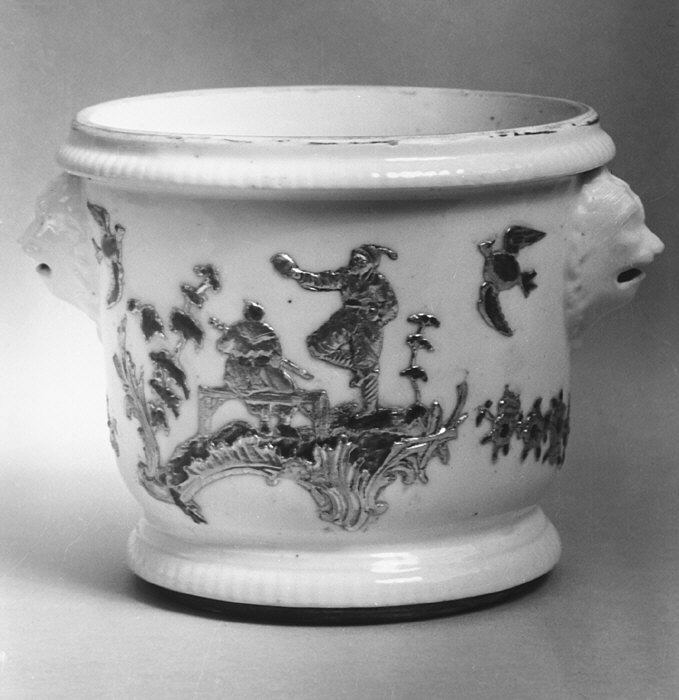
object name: bottle cooler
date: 1801-1900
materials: soft paste porcelain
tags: birds,men,trees